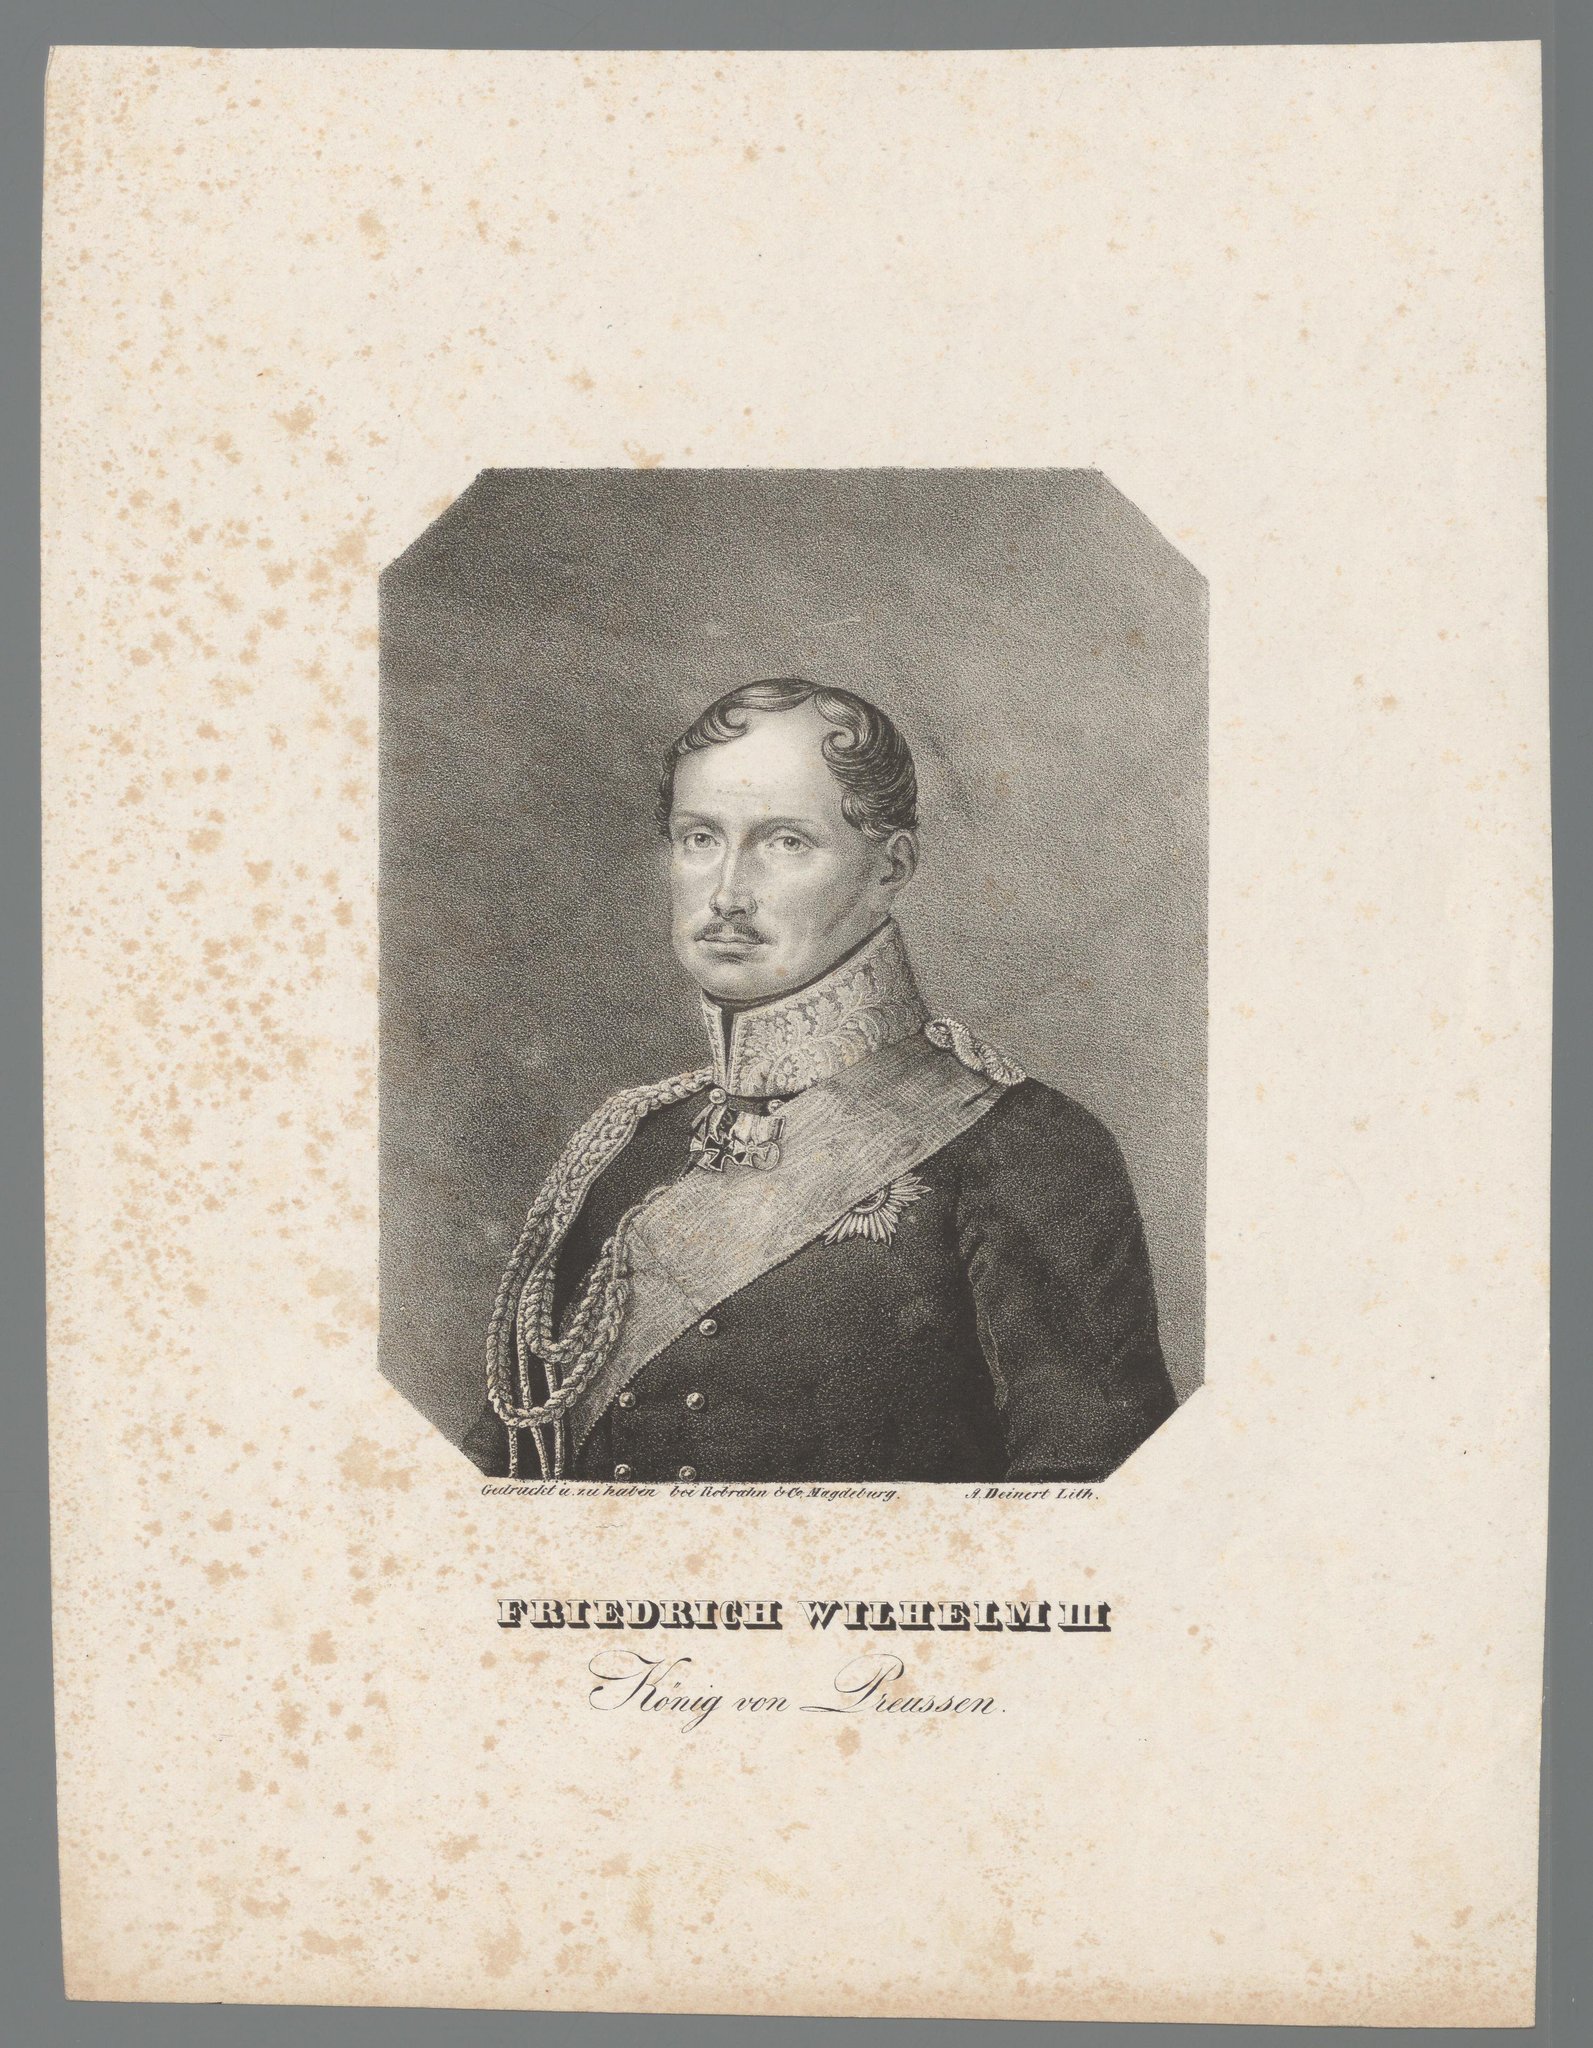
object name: print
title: Portret van Frederik Willem III, koning van Pruisen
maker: a. von deinert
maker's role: print maker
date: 1823-1840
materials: paper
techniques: lithograph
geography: magdeburg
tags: berlin, frederik willem iii koning van pruisen, historical persons, king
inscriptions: collector's mark: Lugt 2228